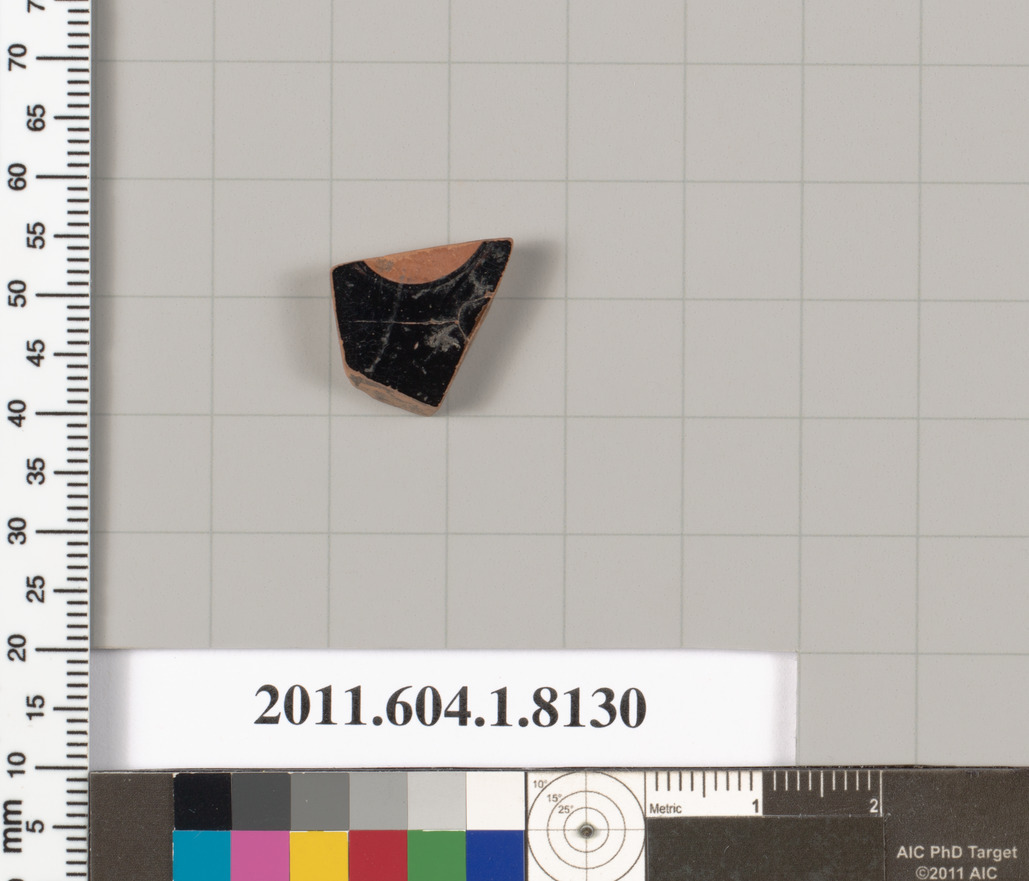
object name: kylix fragment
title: Terracotta fragment of a kylix (drinking cup)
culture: greek, attic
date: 534-468 BCE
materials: terracotta